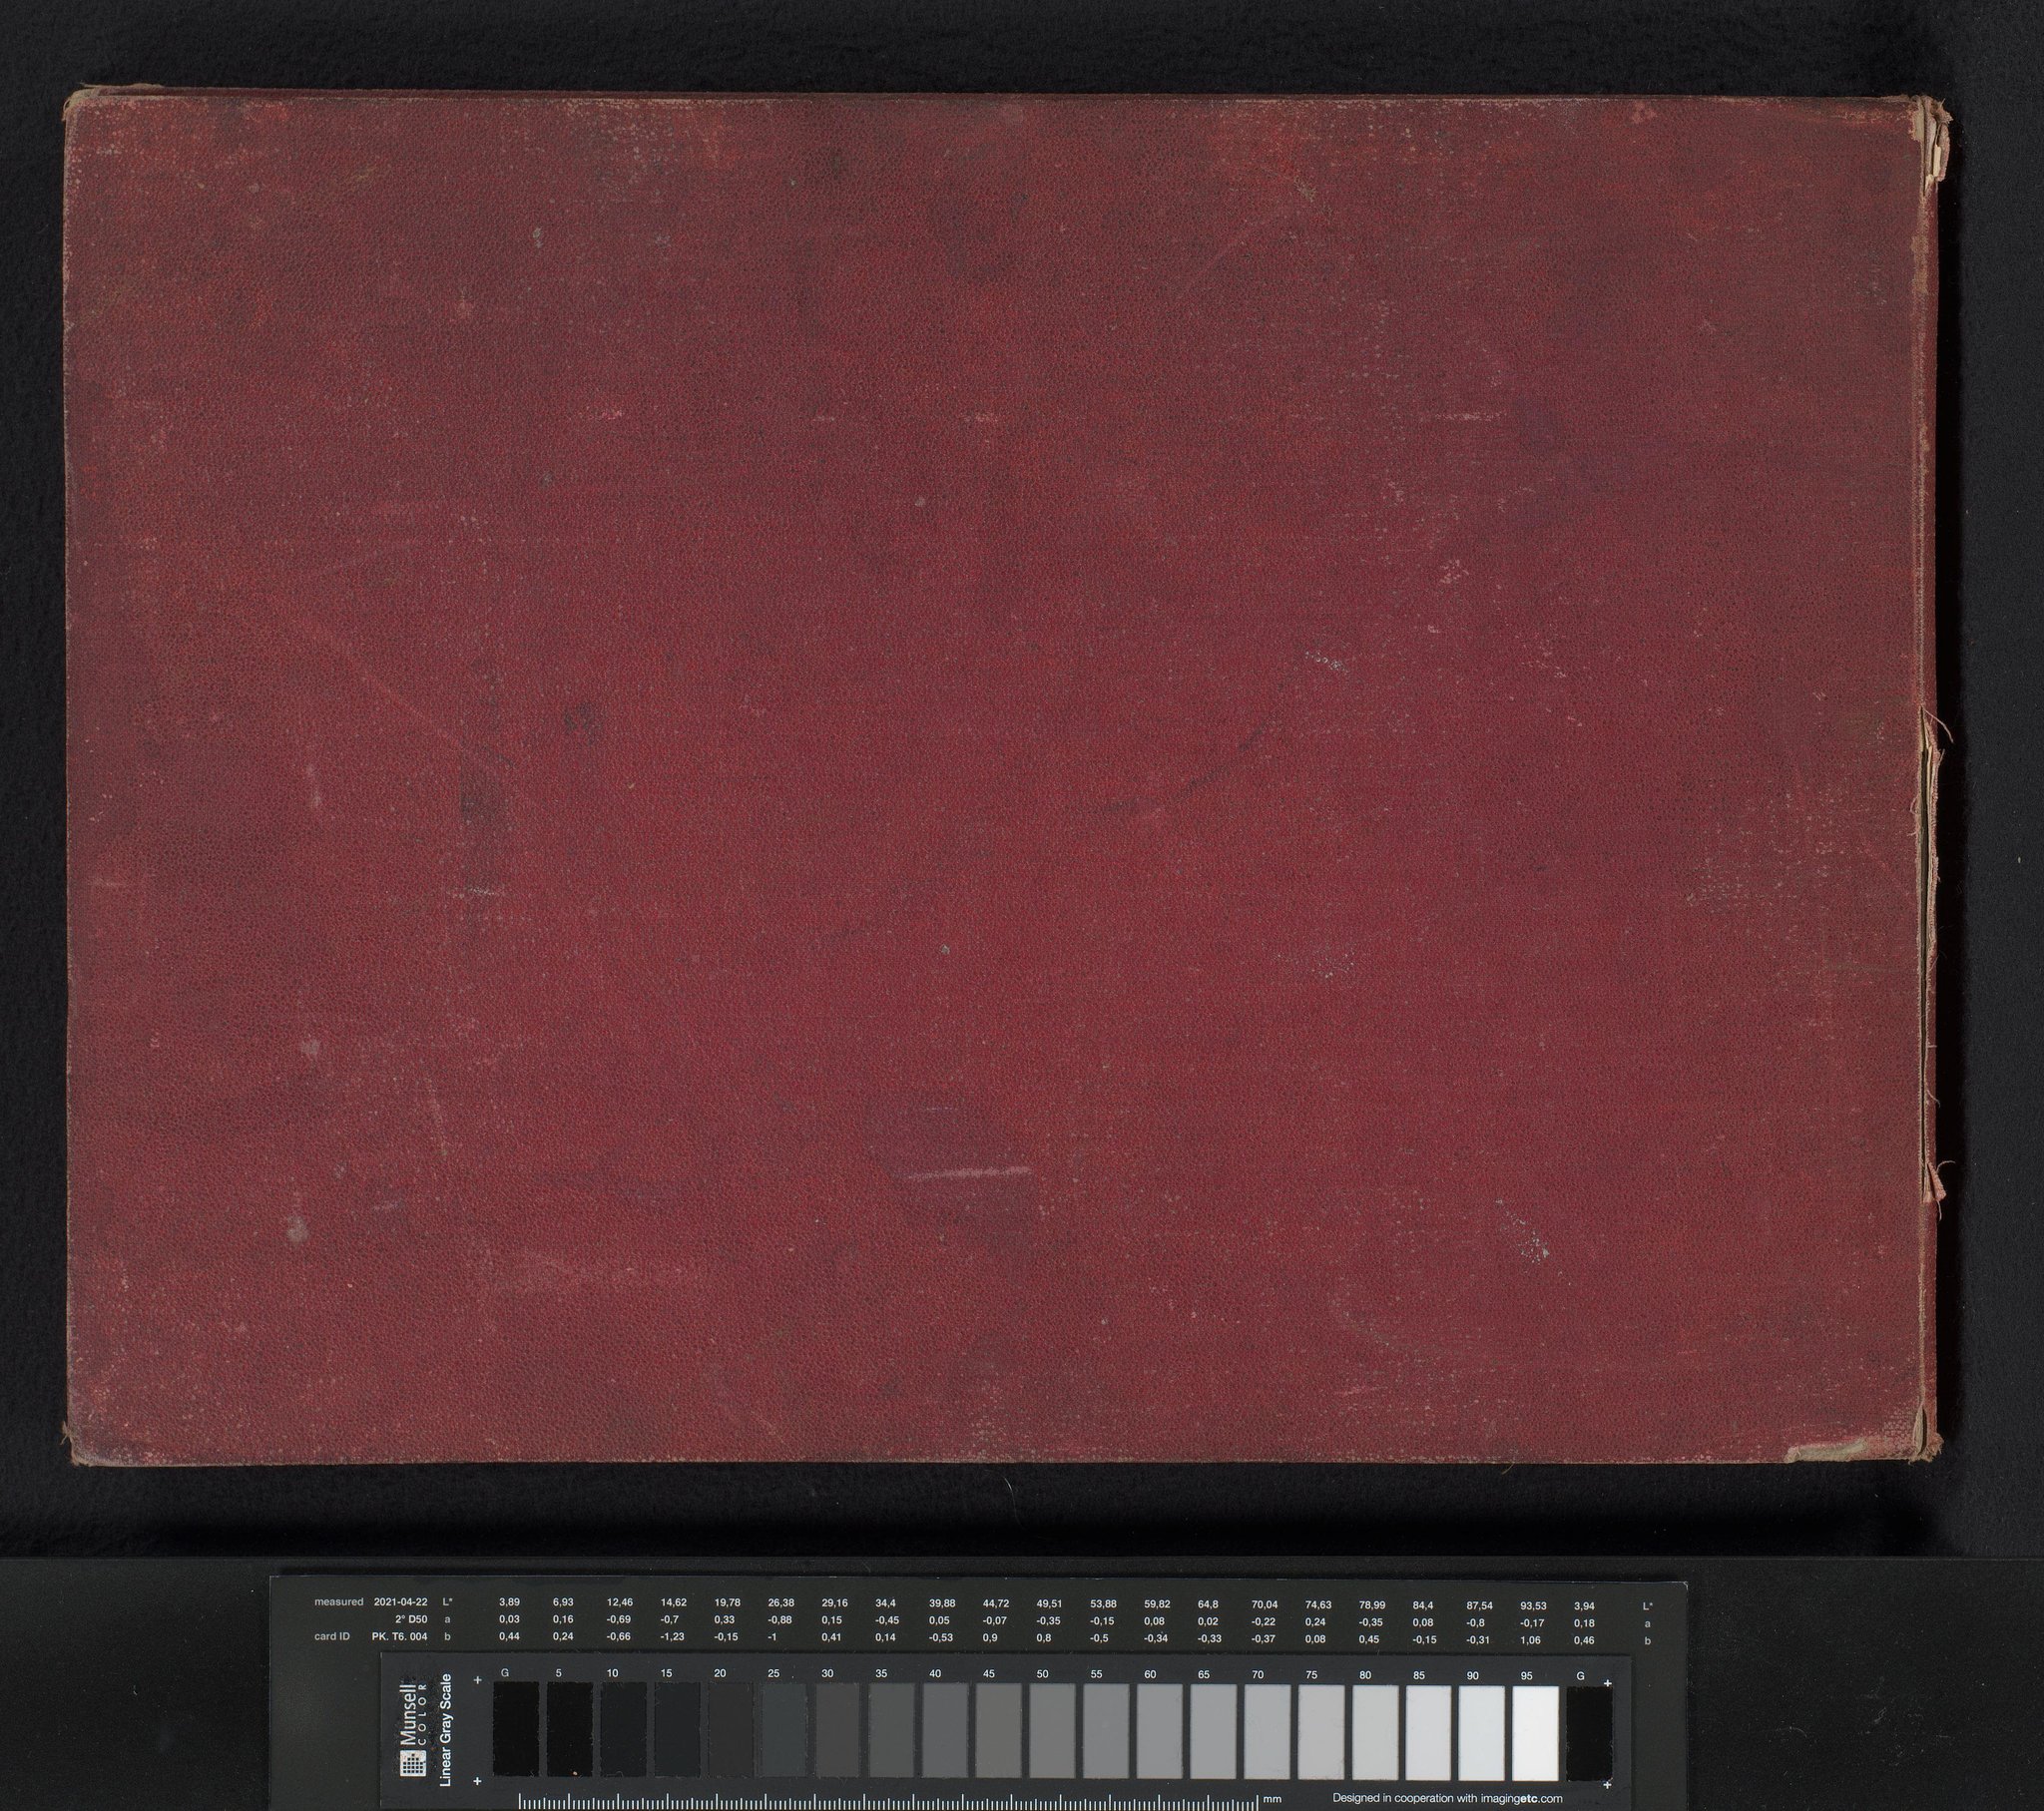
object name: photograph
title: Sala de los Abencerajes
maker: c maufsaise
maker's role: fotograaf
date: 1906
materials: paper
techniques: albumen print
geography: granada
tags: palace, interior ~ representation of a building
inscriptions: number: ‘26’